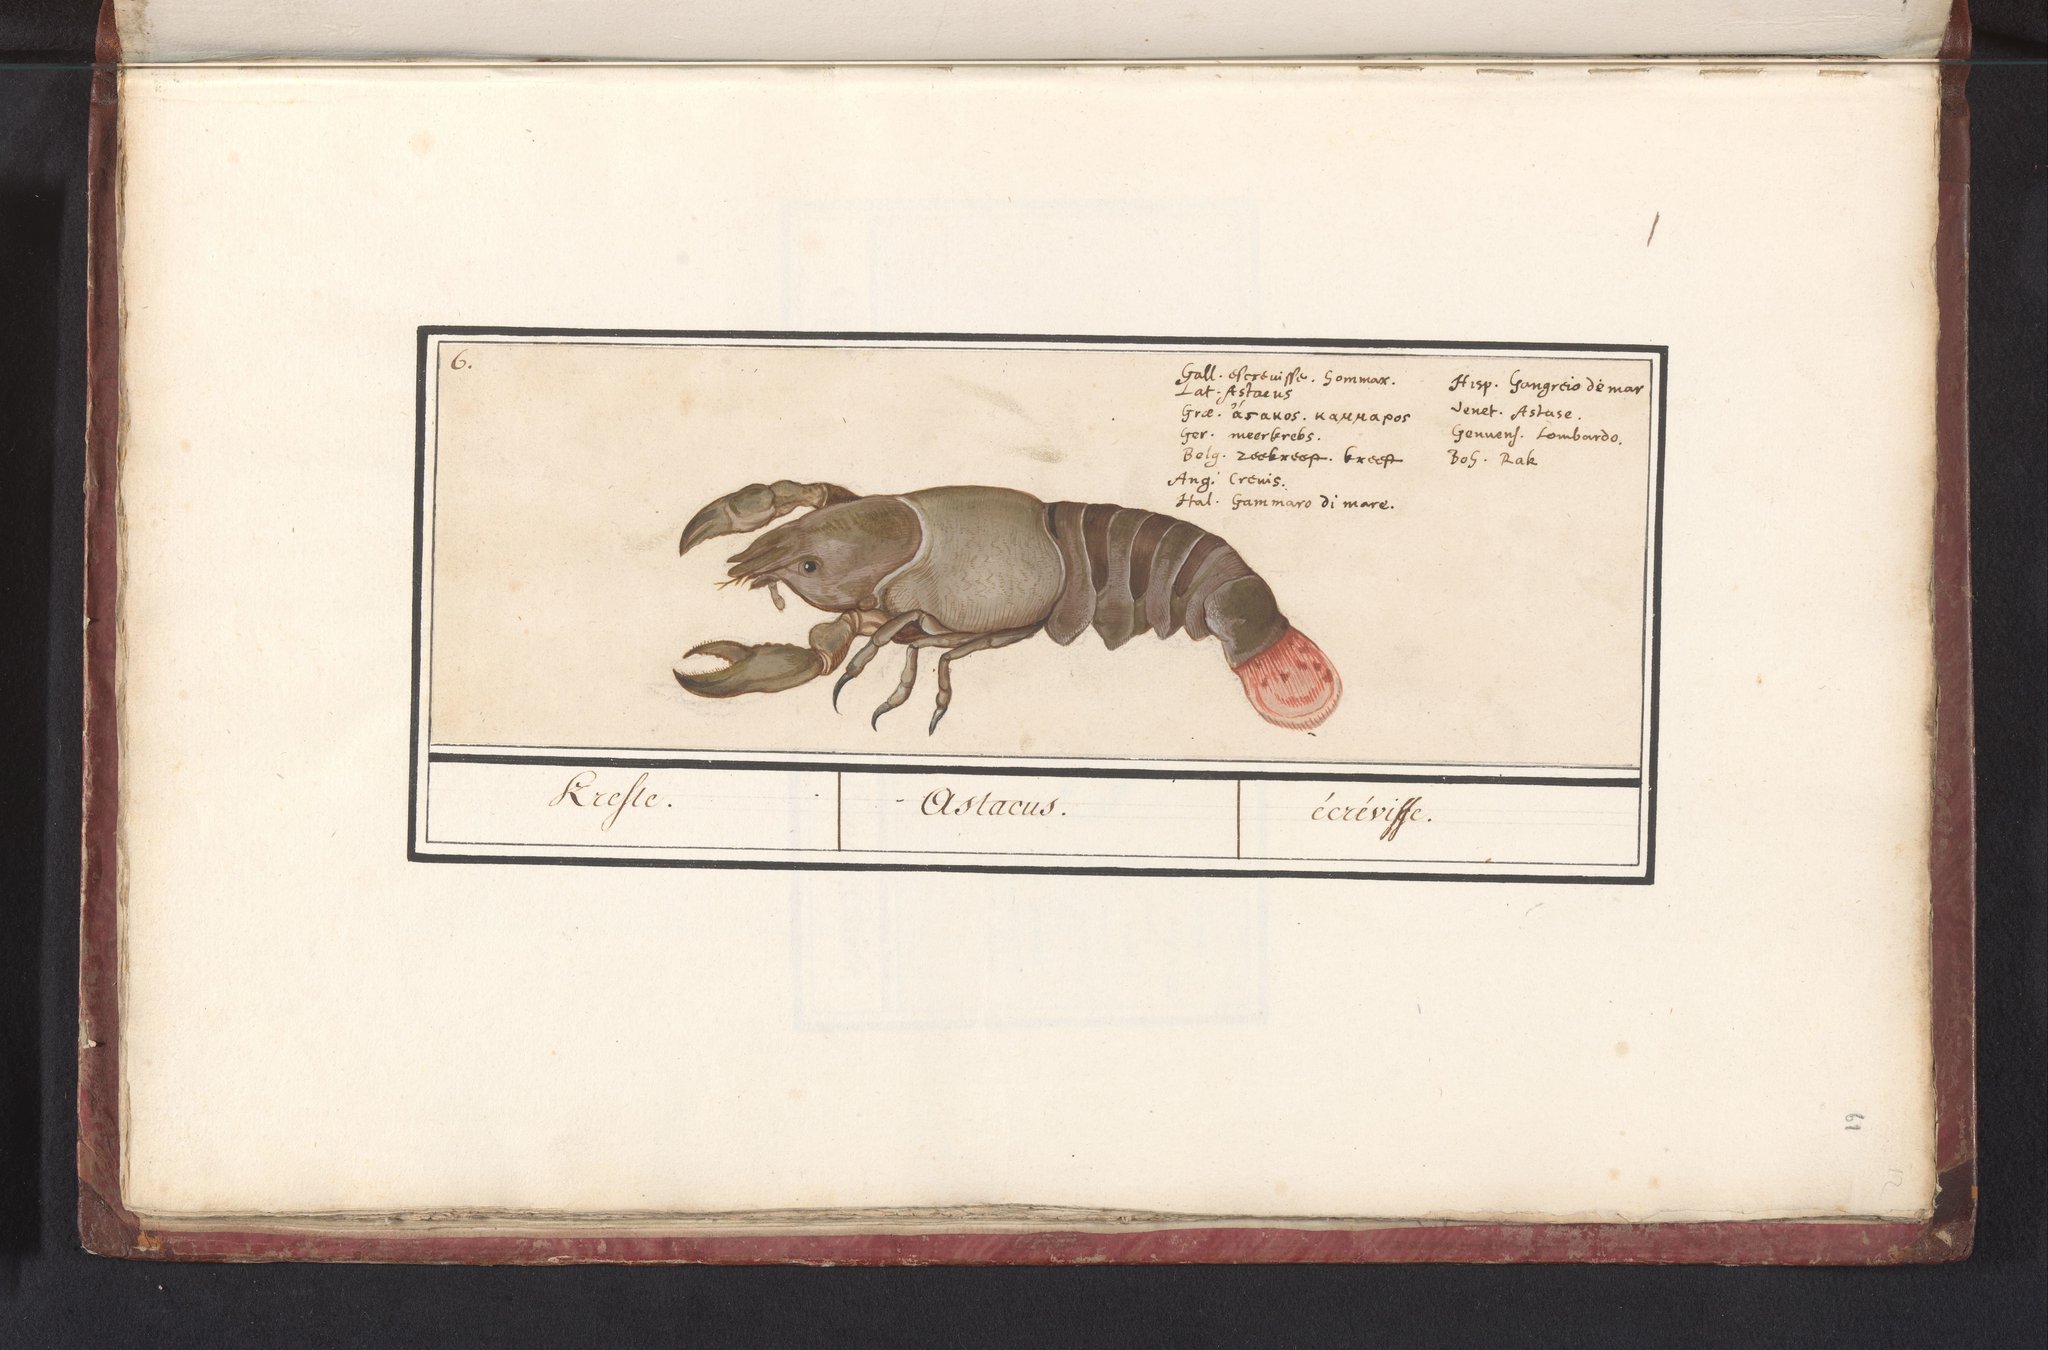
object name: drawing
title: Zeekreeft (Homarus gammarus)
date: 1596-1610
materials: chalk, paint, ink, paper, pencil, watercolor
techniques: brush, pen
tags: crustaceans: lobster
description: Europese zeekreeft. Genummerd linksboven: 6. Rechtsboven de naam in elf talen. Onderdeel van het zesde album met tekeningen van vissen, schelpen en insekten. Zesde van twaalf albums met tekeningen van dieren, vogels en planten bekend rond 1600, gemaakt in opdracht van keizer Rudolf II. Met toelichting in Nederlands, Latijn en Frans.